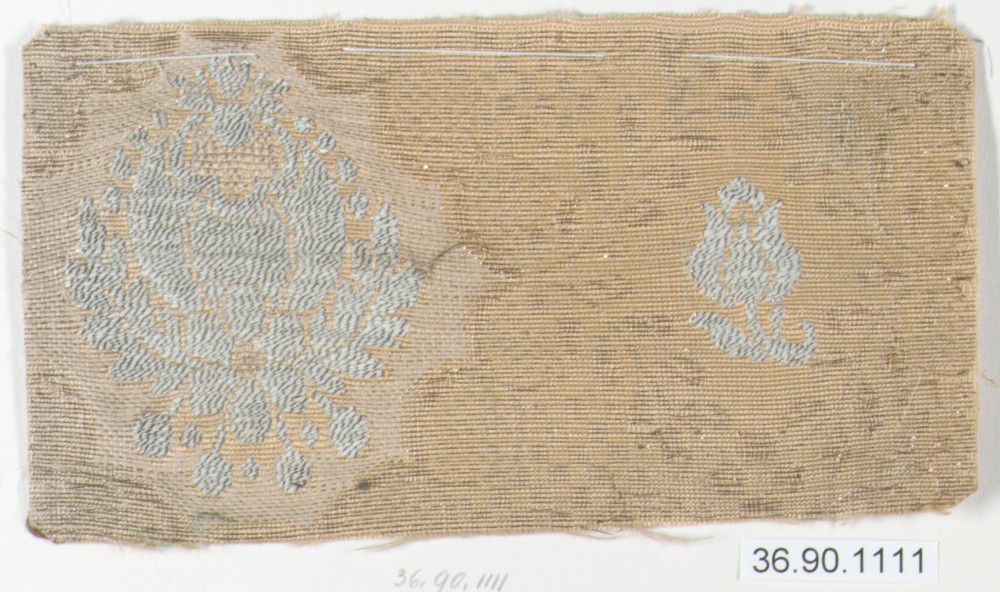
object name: sample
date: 1701-1900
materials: metal thread, silk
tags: flowers